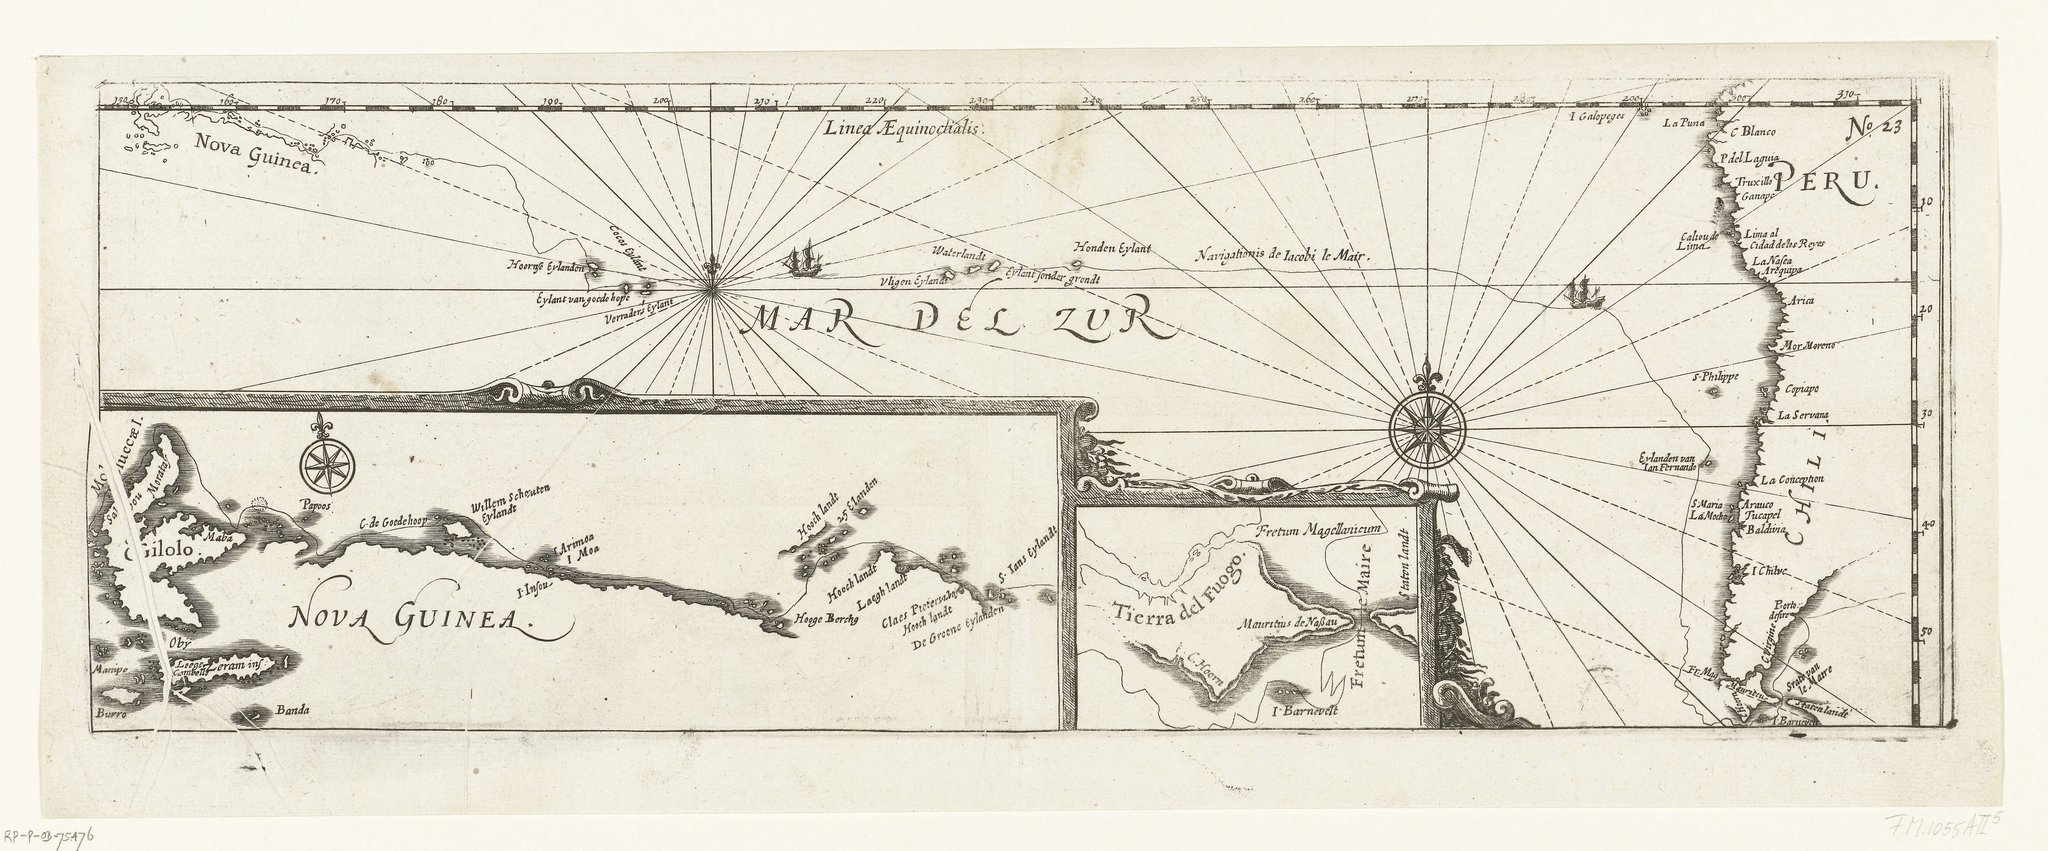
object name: print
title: Kaert, ofte Voyagie, Van Jacob le Maire, bewijst VE. in wat manieren den voorsz Jacob le Maire, door een nieuwe Straet, de Zuyt-zee ghepasseert is, tot in Indien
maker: Anonymous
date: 1617-1619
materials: paper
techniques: engraving, etching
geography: northern netherlands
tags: antwerp, maps of separate countries or regions, landscapes in polar regions, exploration, expedition, voyage of discovery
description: Oorspronkelijke illustraties eerst gebruikt in: Willem Cornelisz Schouten, Iovrnael ofte beschryvinghe van de wonderlijcke reyse, ghedaen door Willem Cornelisz Schouten van Hoorn, inde iaren 1615. 1616. en 1617, Willem Jansz Blaeu, Amsterdam, 1618. Kopieën naar deze platen gebruikt in: J. van Spilbergen, Oost ende West-Indische spiegel der 2 leste navigatiën, ghedaen inden jaeren 1614, 15, 16, 17, ende 18. daer in vertoont woort, in wat gestalt Ioris van Speilbergen door de Magellanes de werelt rontom geseylt heeft ...; met de Australische navigatiën, van Iacob le Maire, ... met veel wonders ... in 26 coperen platen afghebeelt, N. Geelkerck, Leiden 1619. Later opnieuw gebruikt in : I. Commelin, Begin ende voortgangh, van de Vereenighde Nederlantsche Geoctroyeerde Oost-Indische Compagnie, J. Janssonius, Amsterdam 1646. Genummerd: No. 23.